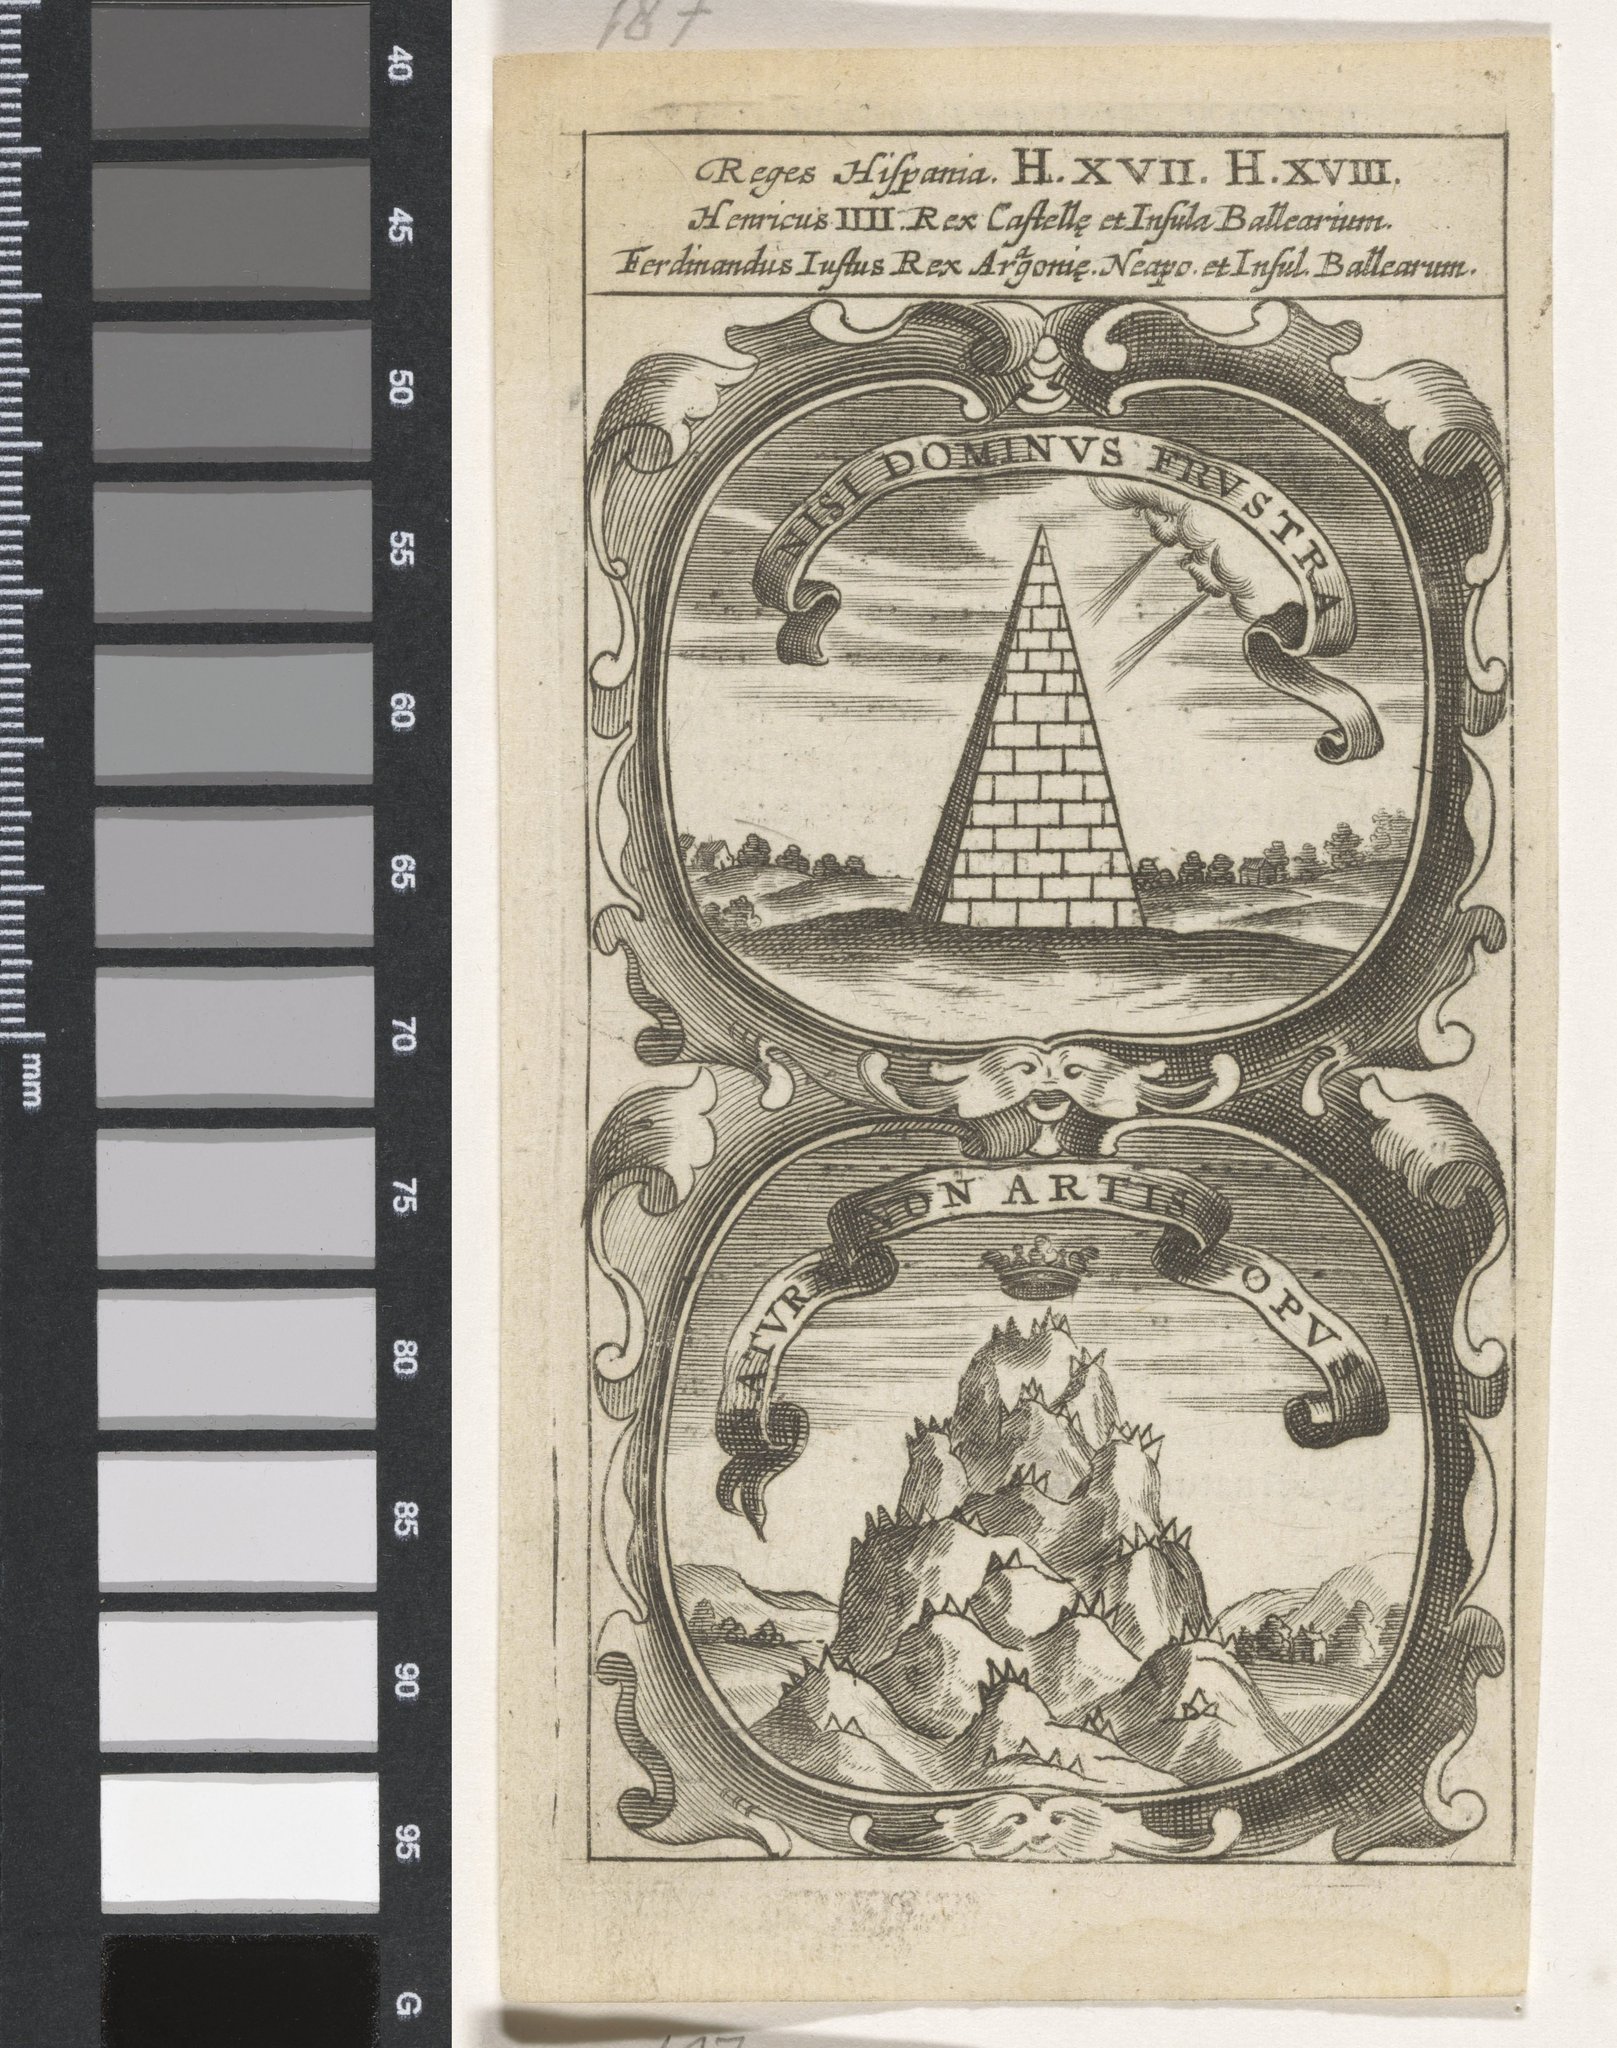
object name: print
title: Symbola Divina et Humana Pontificum Imperatorum Regum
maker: Anonymous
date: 1666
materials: paper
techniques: engraving, letterpress printing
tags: crown (symbol of sovereignty), quadrangular pyramid, winds, mountains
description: Een embleem met twee voorstellingen. Boven een landschap met een stenen piramide. De wind blaast tegen het bouwsel aan. Onder zweeft een kroon boven een berg bekleed met stekels. Het betreffen deviezen van koning Hendrik IV van Castilië en Ferdinand II van Aragon.